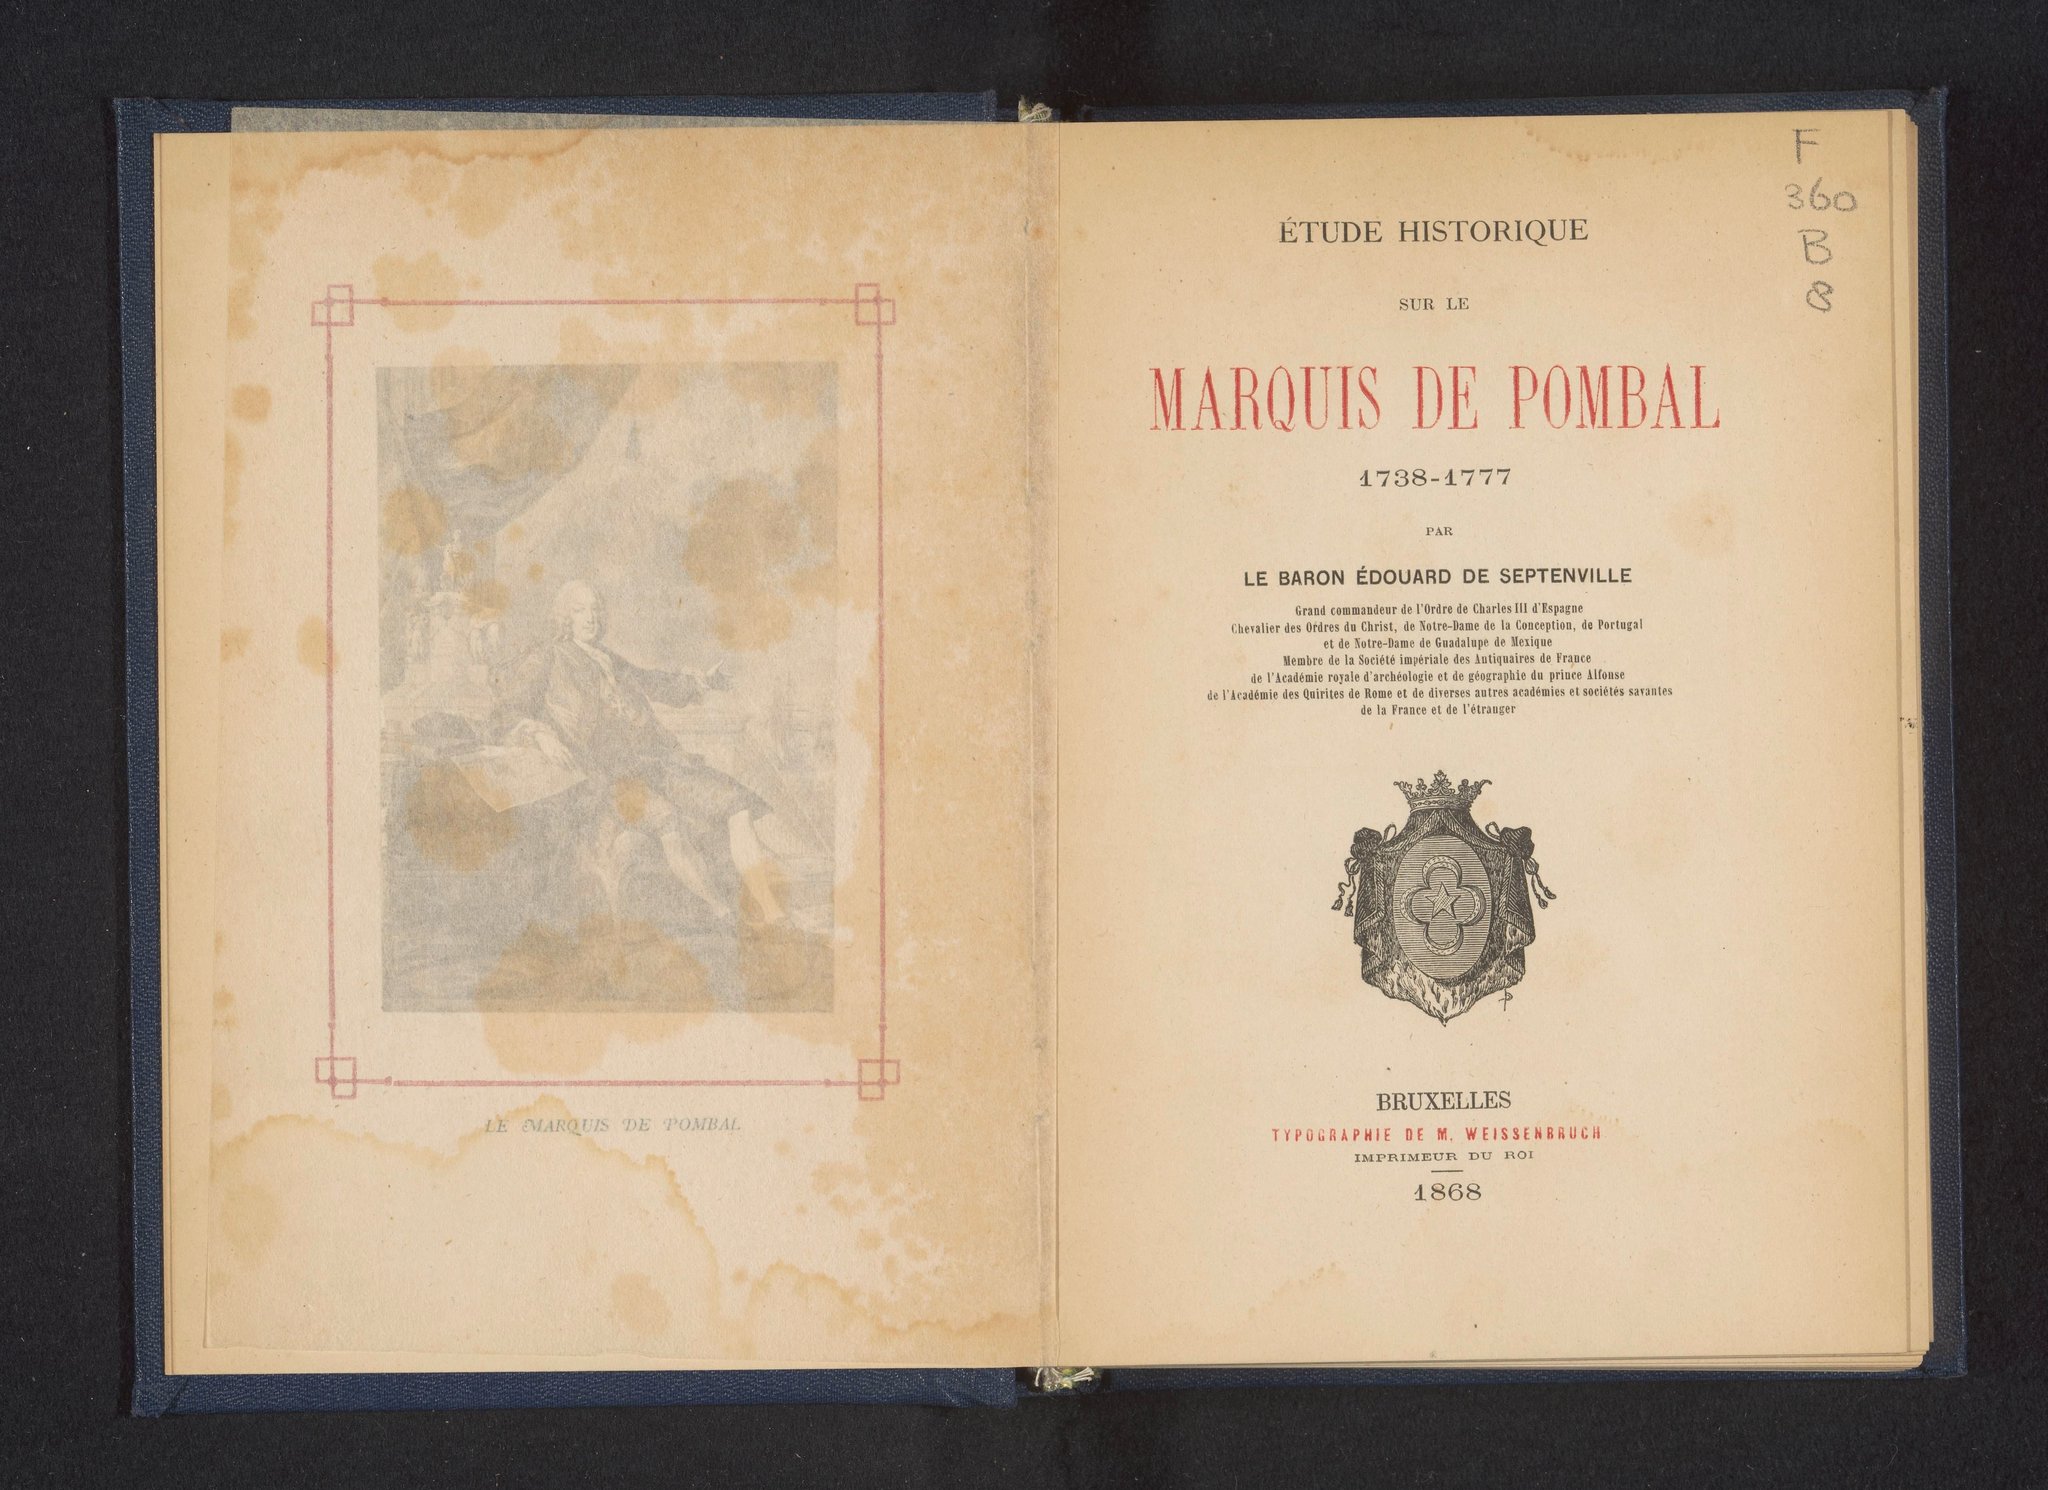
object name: book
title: Étude historique sur le marquis de Pombal, 1738-1777 / par le baron Édouard de Septenville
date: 1868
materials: cardboard, linen, paper, photographic support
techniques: albumen print, decorated paper, printing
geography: brussels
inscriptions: annotation: ‘SEPT/ 2000’